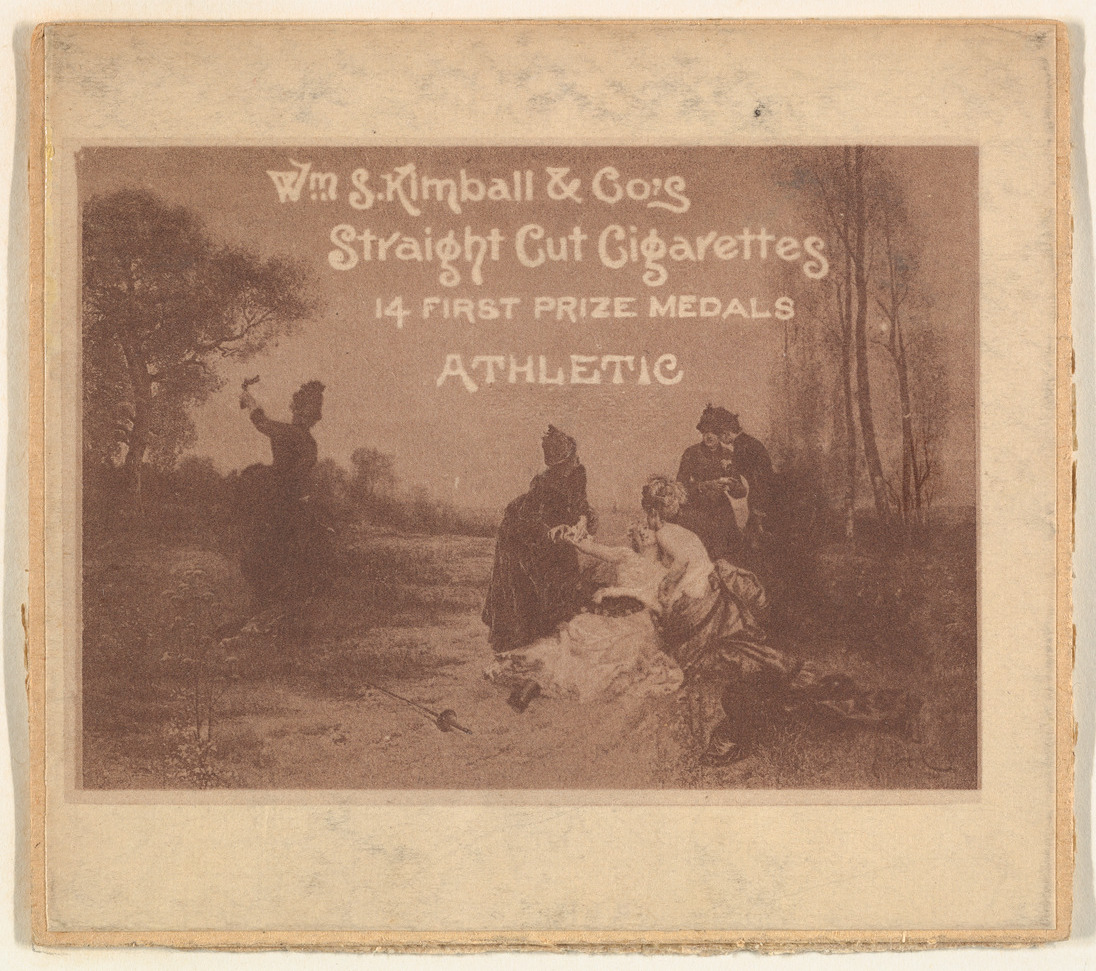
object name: print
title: Athletic, from the Sports and Art Subjects series (N197) issued by Wm. S. Kimball & Co.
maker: william s. kimball & company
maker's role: publisher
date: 1889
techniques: color lithograph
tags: women